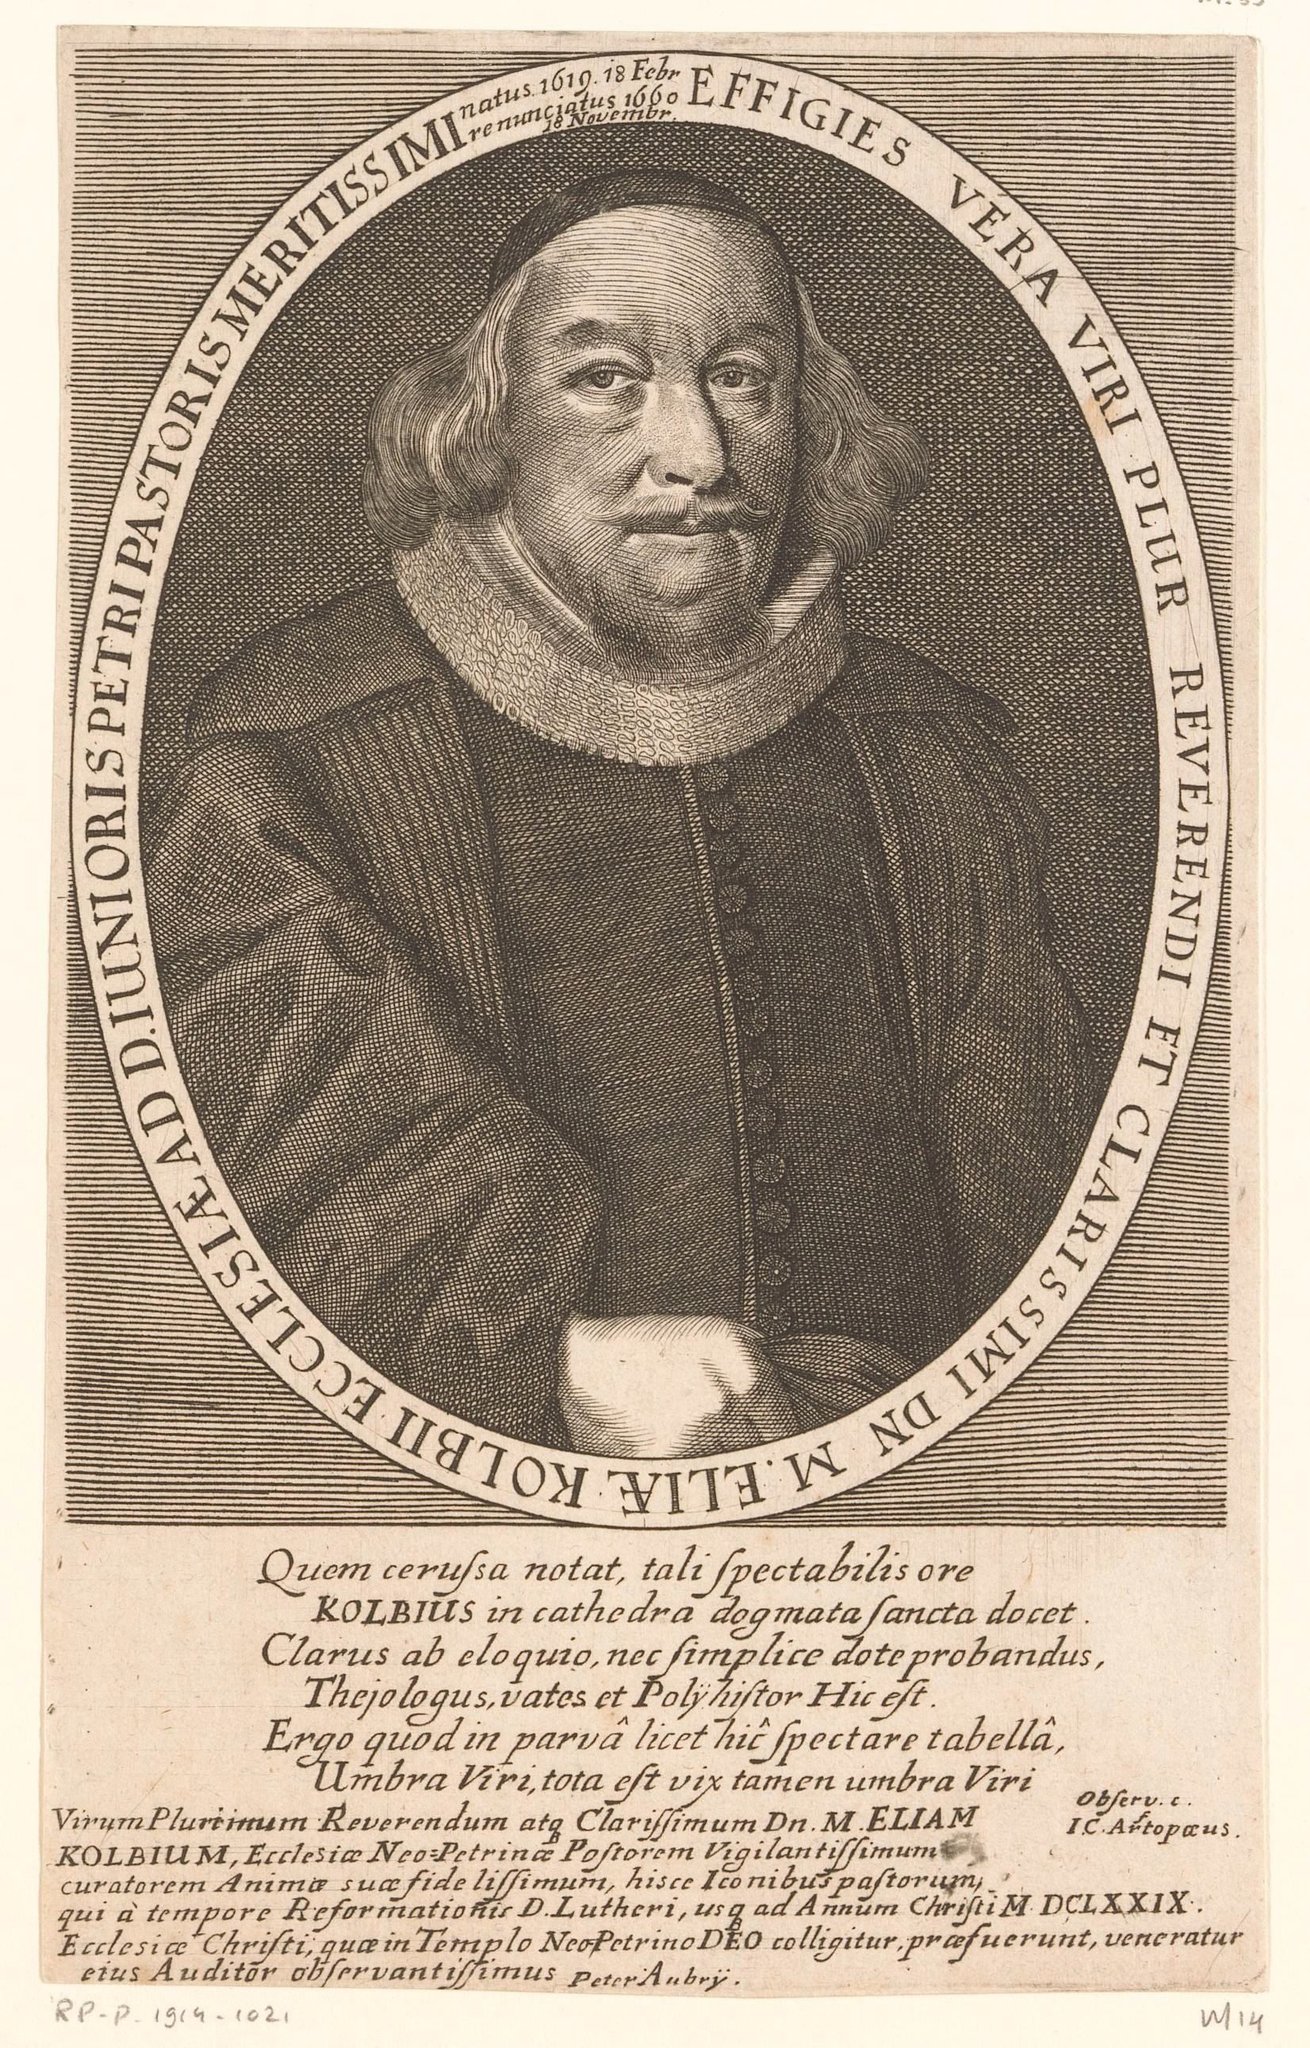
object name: print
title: Portret van Elias Kolb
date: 1669-1686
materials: paper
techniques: engraving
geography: straatsburg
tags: clergyman, historical persons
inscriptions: collector's mark: Lugt 2228